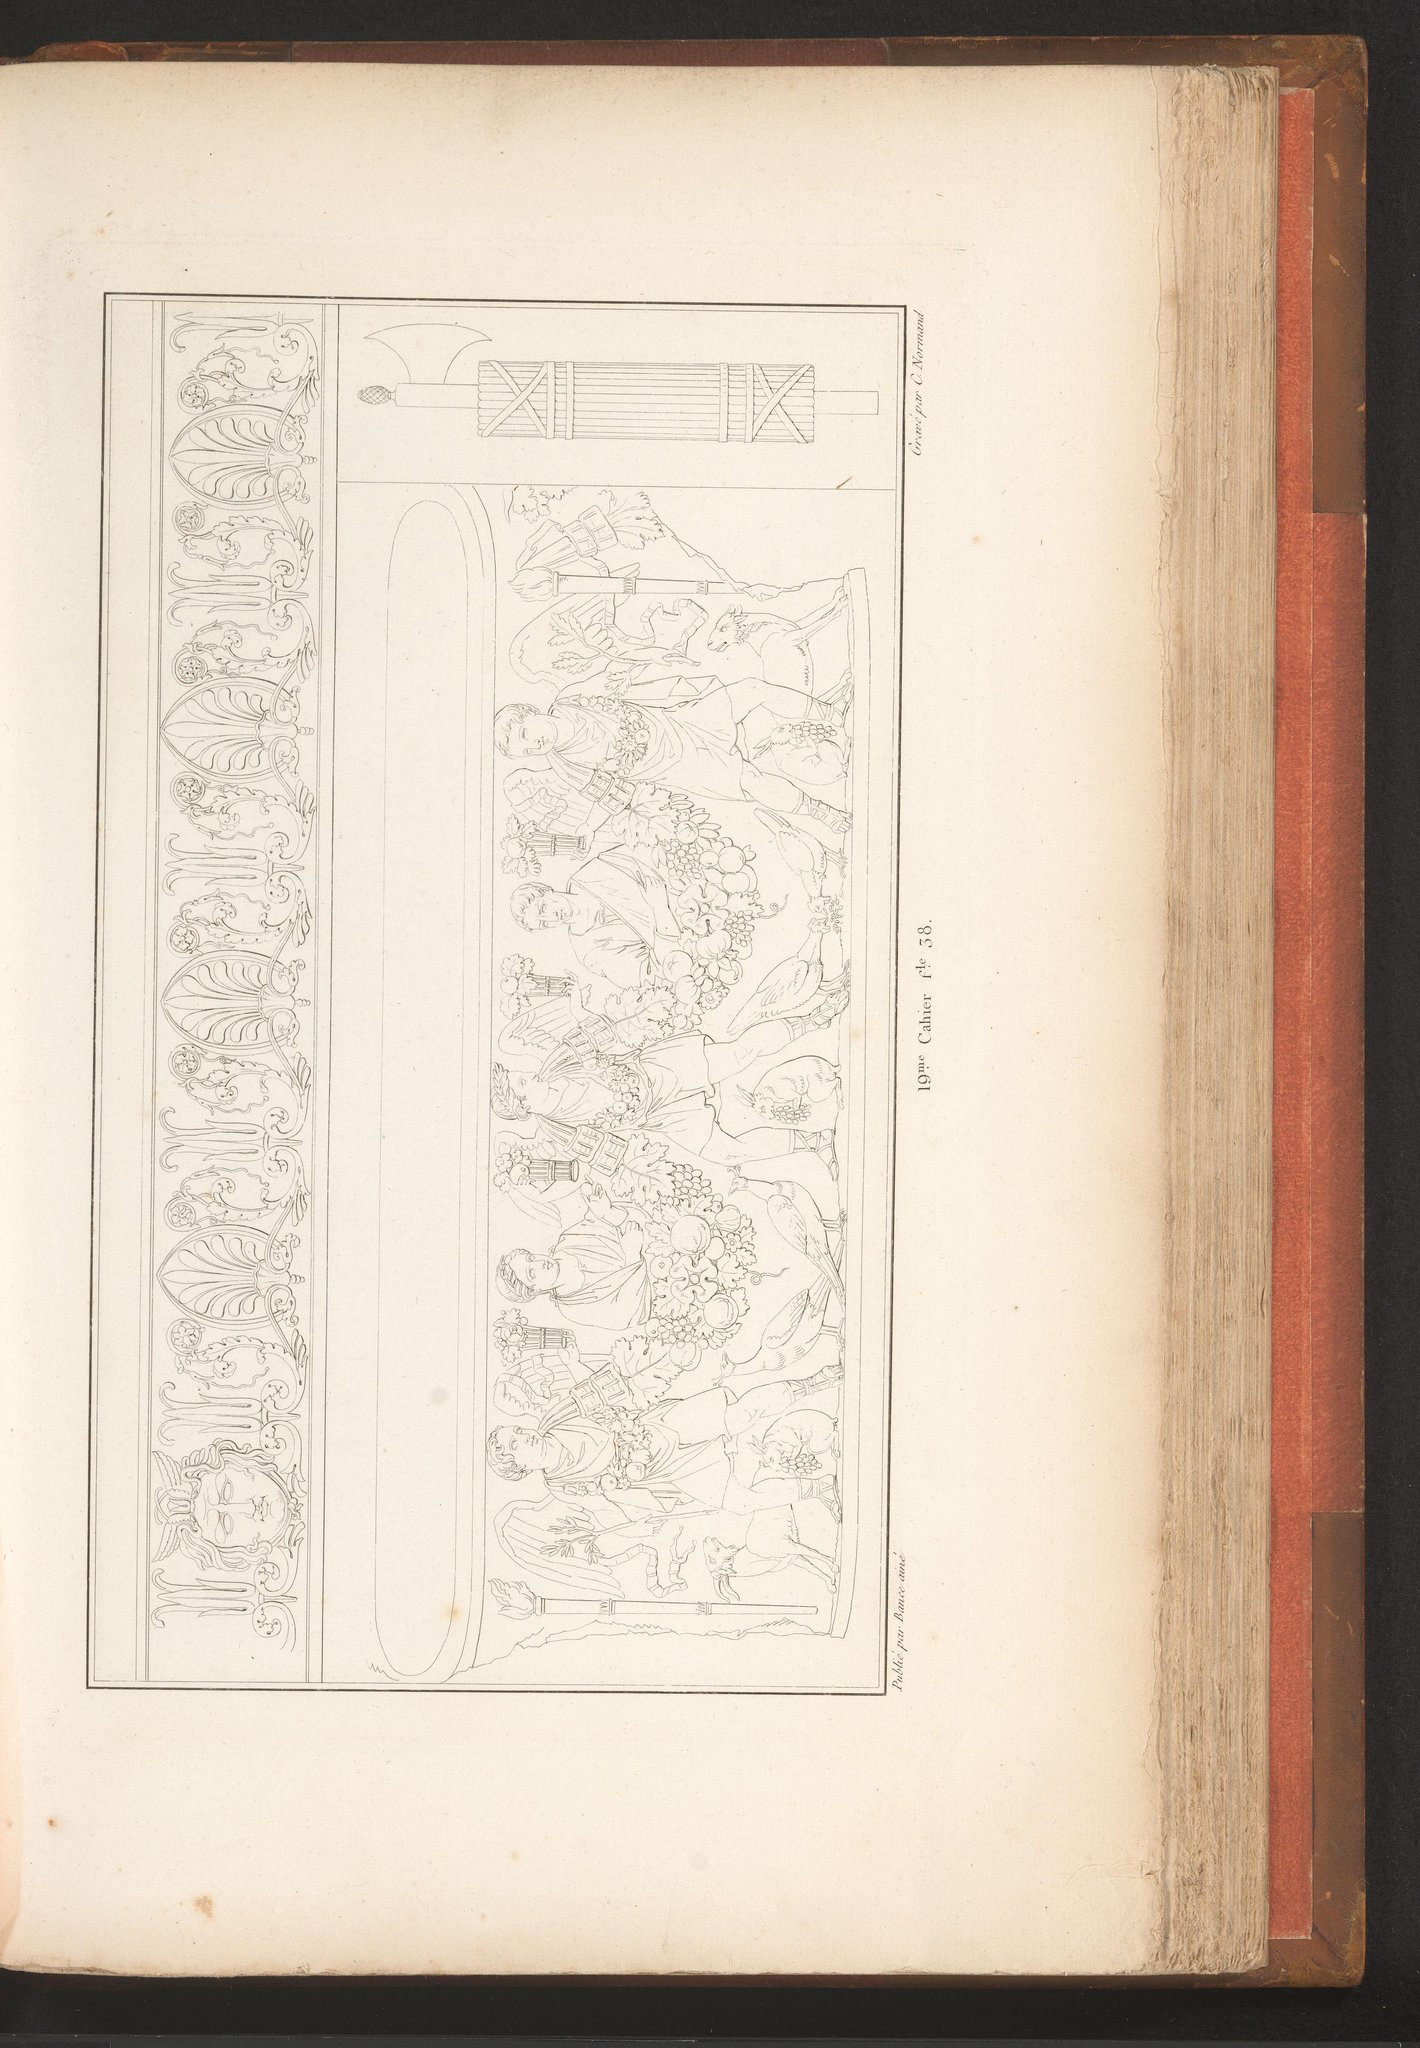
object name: ornament print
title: Twee friezen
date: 1820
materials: paper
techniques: etching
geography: paris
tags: ornaments ~ art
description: Ornamentprent met twee friezen. Onderdeel (19e. Cah.er f.le 38) van het prentalbum met twee series van in totaal 138 ornamentprenten door Beauvallet en Normand, 'Fragmens d'Ornemens dans le Style Antique'.